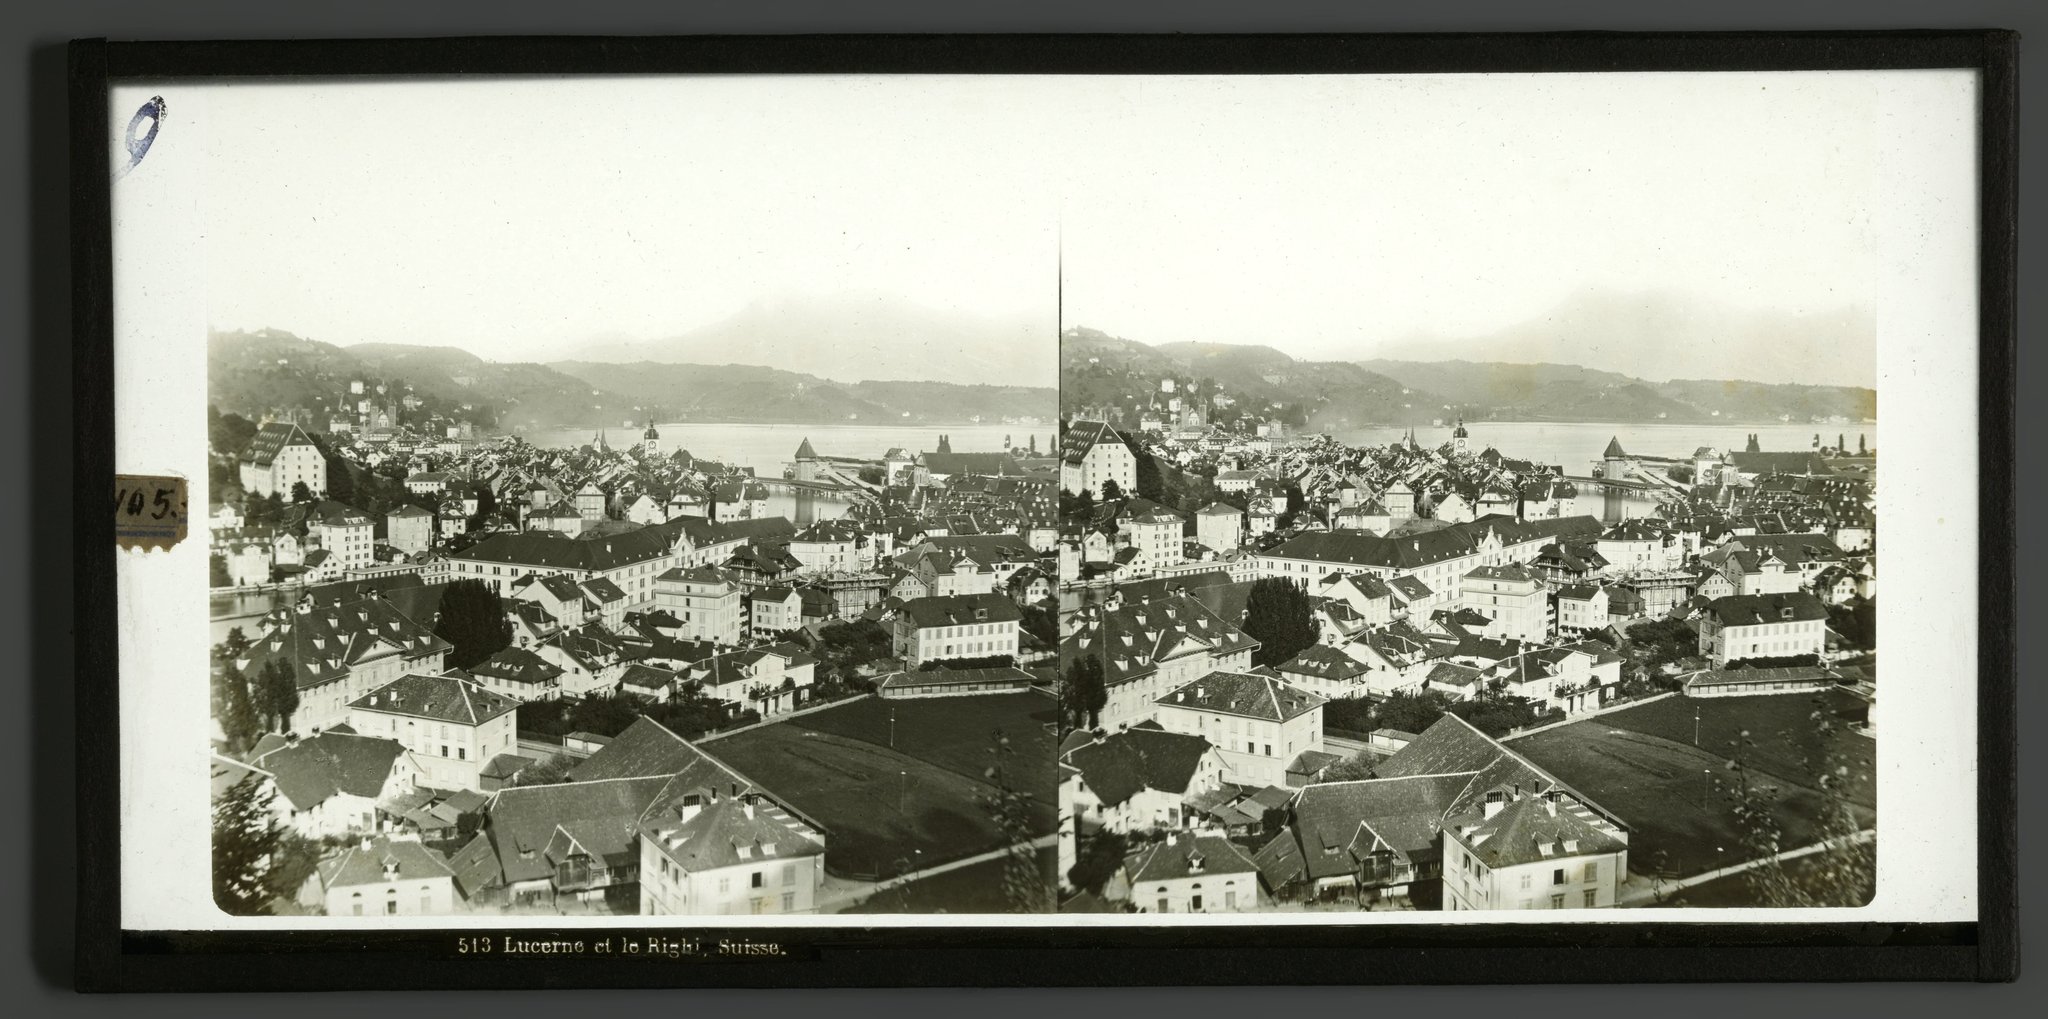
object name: stereoscopic photograph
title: Gezicht op Luzern en de Rigi te Zwitserland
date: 1860-1870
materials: glass, paper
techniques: slide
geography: lucerne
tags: city-view in general; 'veduta', lake, mountains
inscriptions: inscription: ‘513 Lucerne et le Righi, Suisse’, number: ‘9’, number: ‘105’